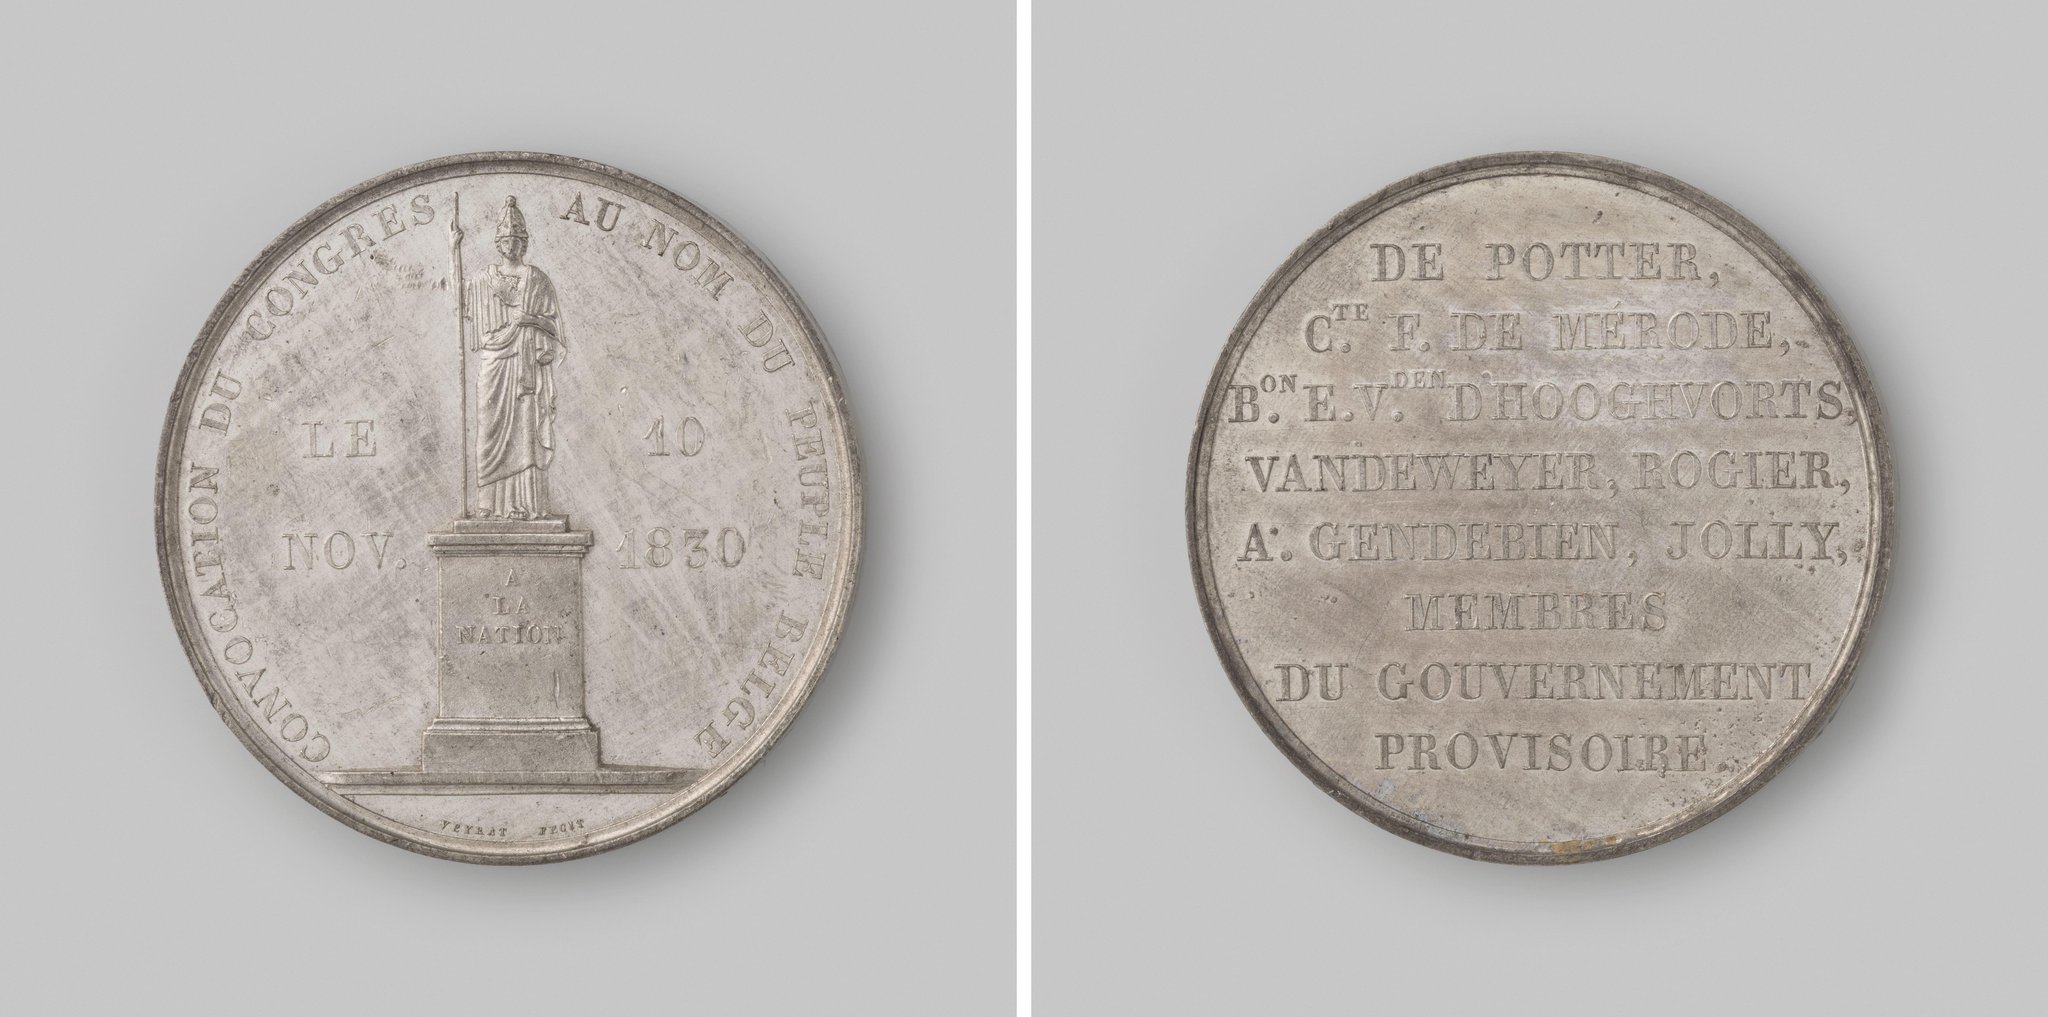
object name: history medal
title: Samenroeping van het Belgisch Congres 1830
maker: adrien hippolyte veyrat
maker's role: medailleur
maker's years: 1803-1883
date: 1830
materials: tin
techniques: striking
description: Tinen penning, op de voorzijde het beeld van een gehelmde man met staf op een sokkel, met omschrift, op de keerzijde acht regels tekst.